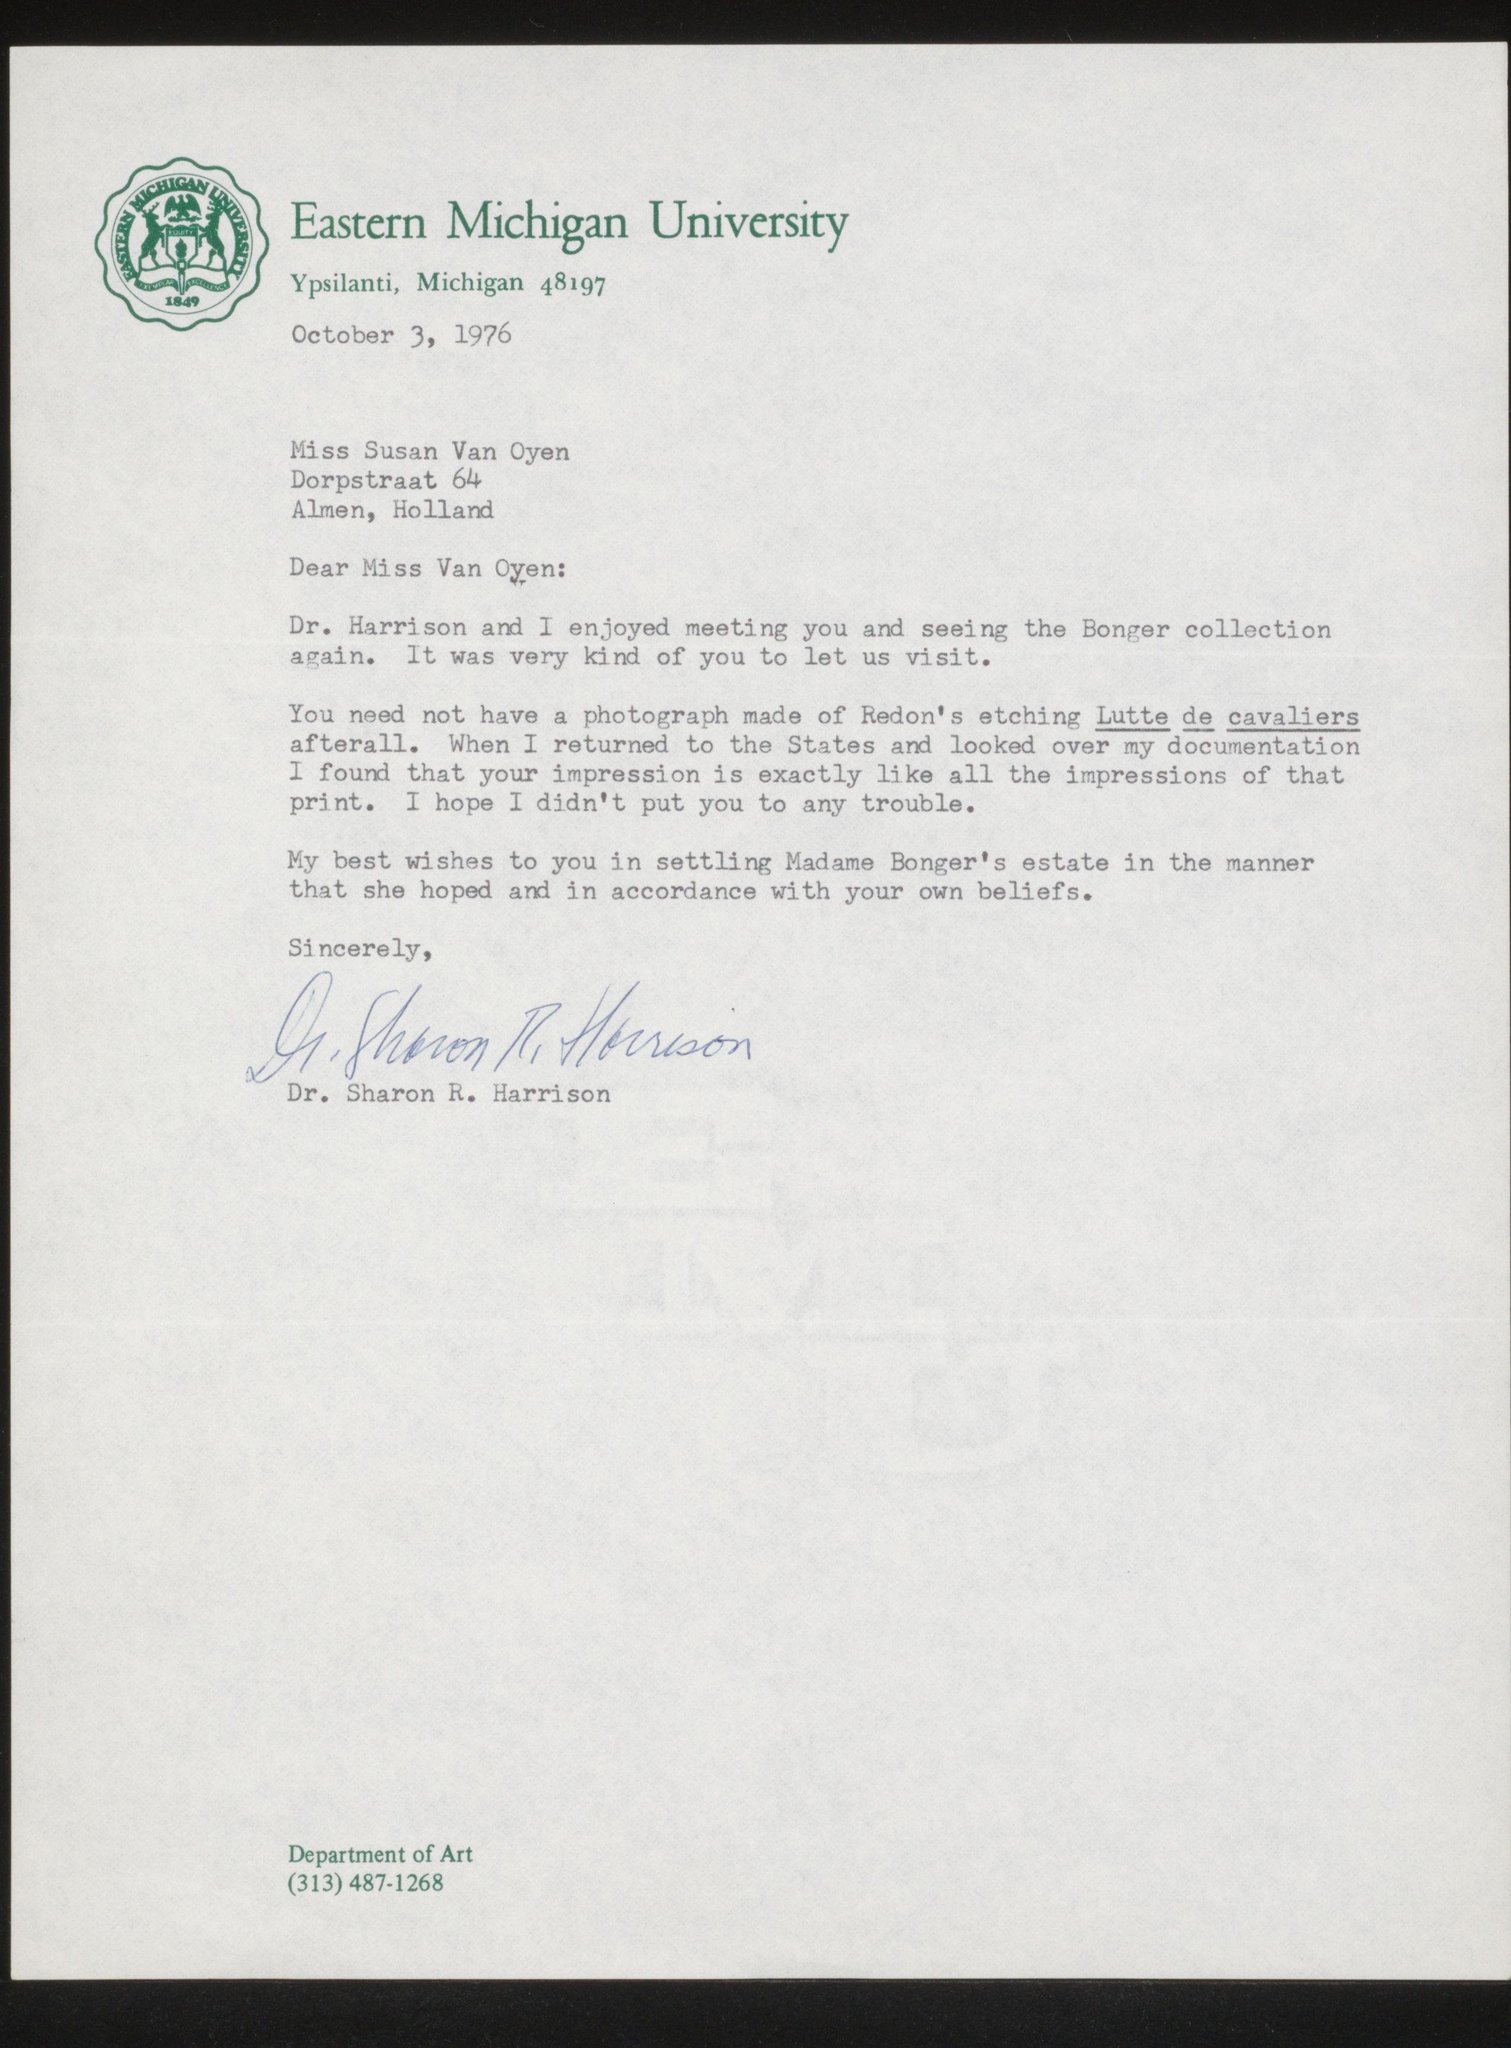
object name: letter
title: Brief aan Suze van Oyen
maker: sharon rich-harrison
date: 1976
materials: ink, paper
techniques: pen, typewriting, writing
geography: michigan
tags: suze van oyen, paris, painter, print maker, draughtsman, odilon redon, amsterdam, andries bonger, the graphic arts, art collecting